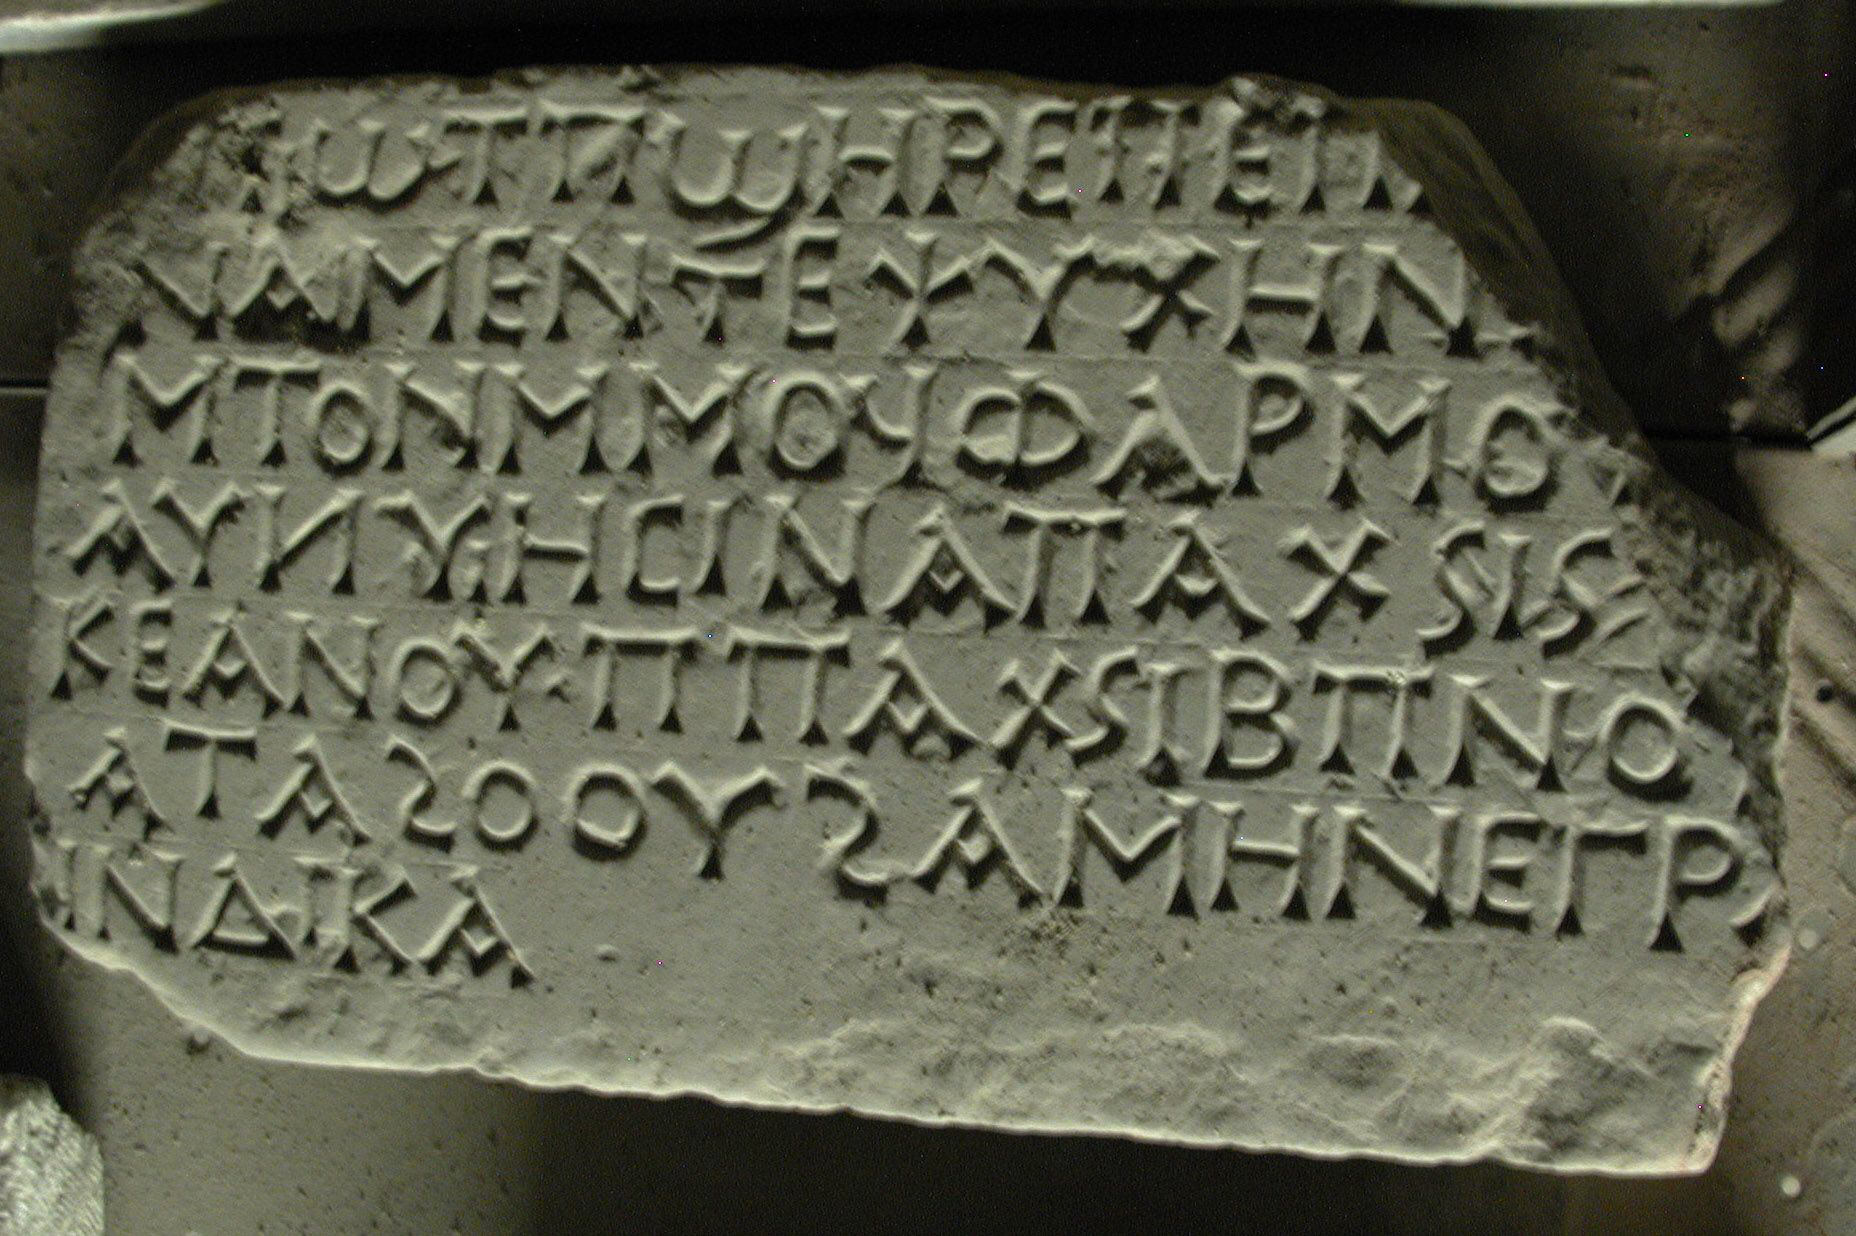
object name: stele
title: Inscribed Stele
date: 501-700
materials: limestone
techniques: incising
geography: egypt